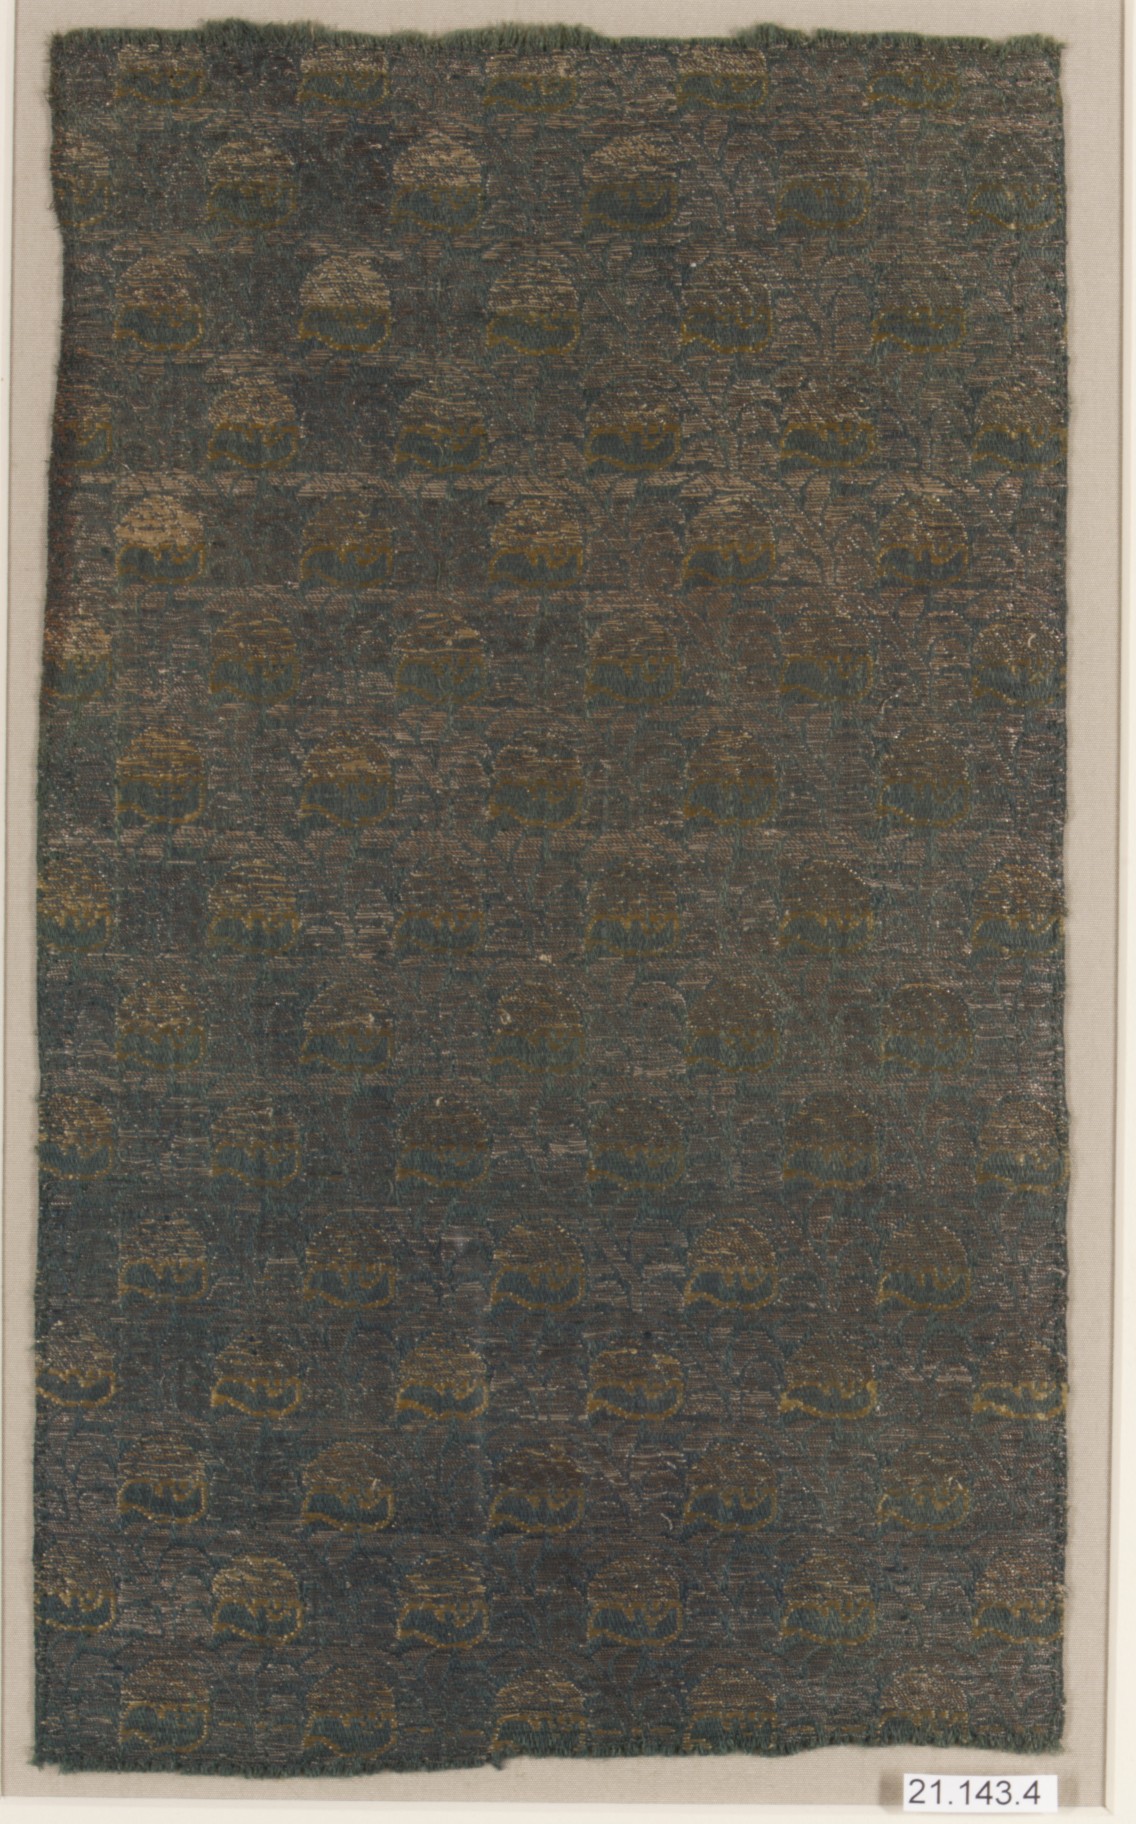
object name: brocade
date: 1801-1900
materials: metal thread, silk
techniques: brocade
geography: india